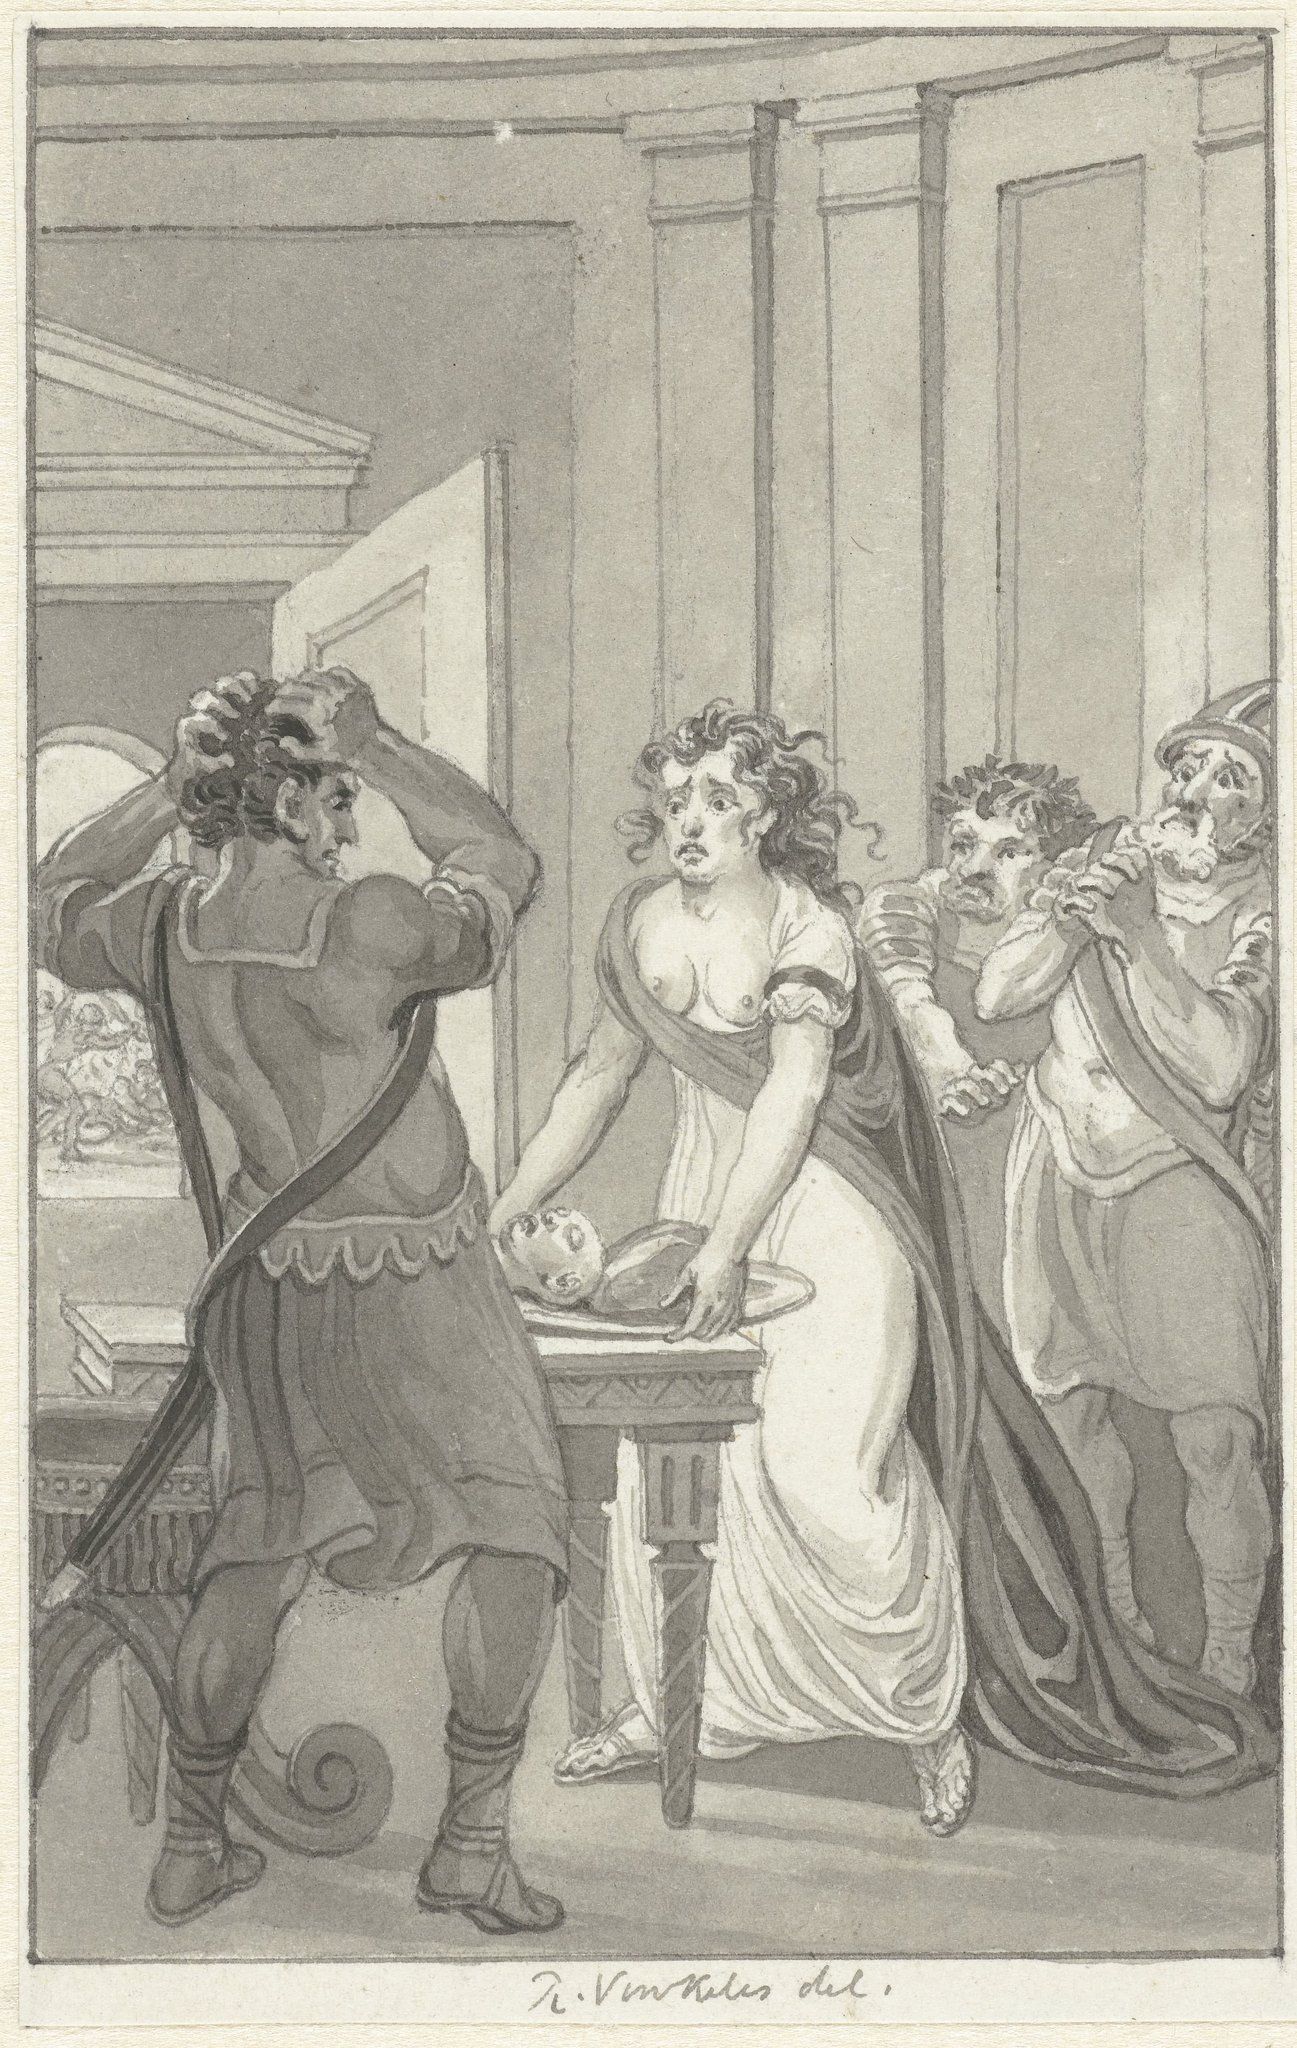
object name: drawing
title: Gruwelen in de Joodse Oorlog: een vrouw met het hoofd van een kind op een schotel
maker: reinier vinkeles (i)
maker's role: draughtsman, print maker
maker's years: 1741-1816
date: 1804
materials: ink, paper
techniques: brush, pen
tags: events and situations from classical history (70), war, massacre ~ war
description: Ontwerp voor gravure door Ludwig Portman in M. Stuart's `Romeinsche Geschiedenissen', 1804; dl. 25, t.o. p. 502.